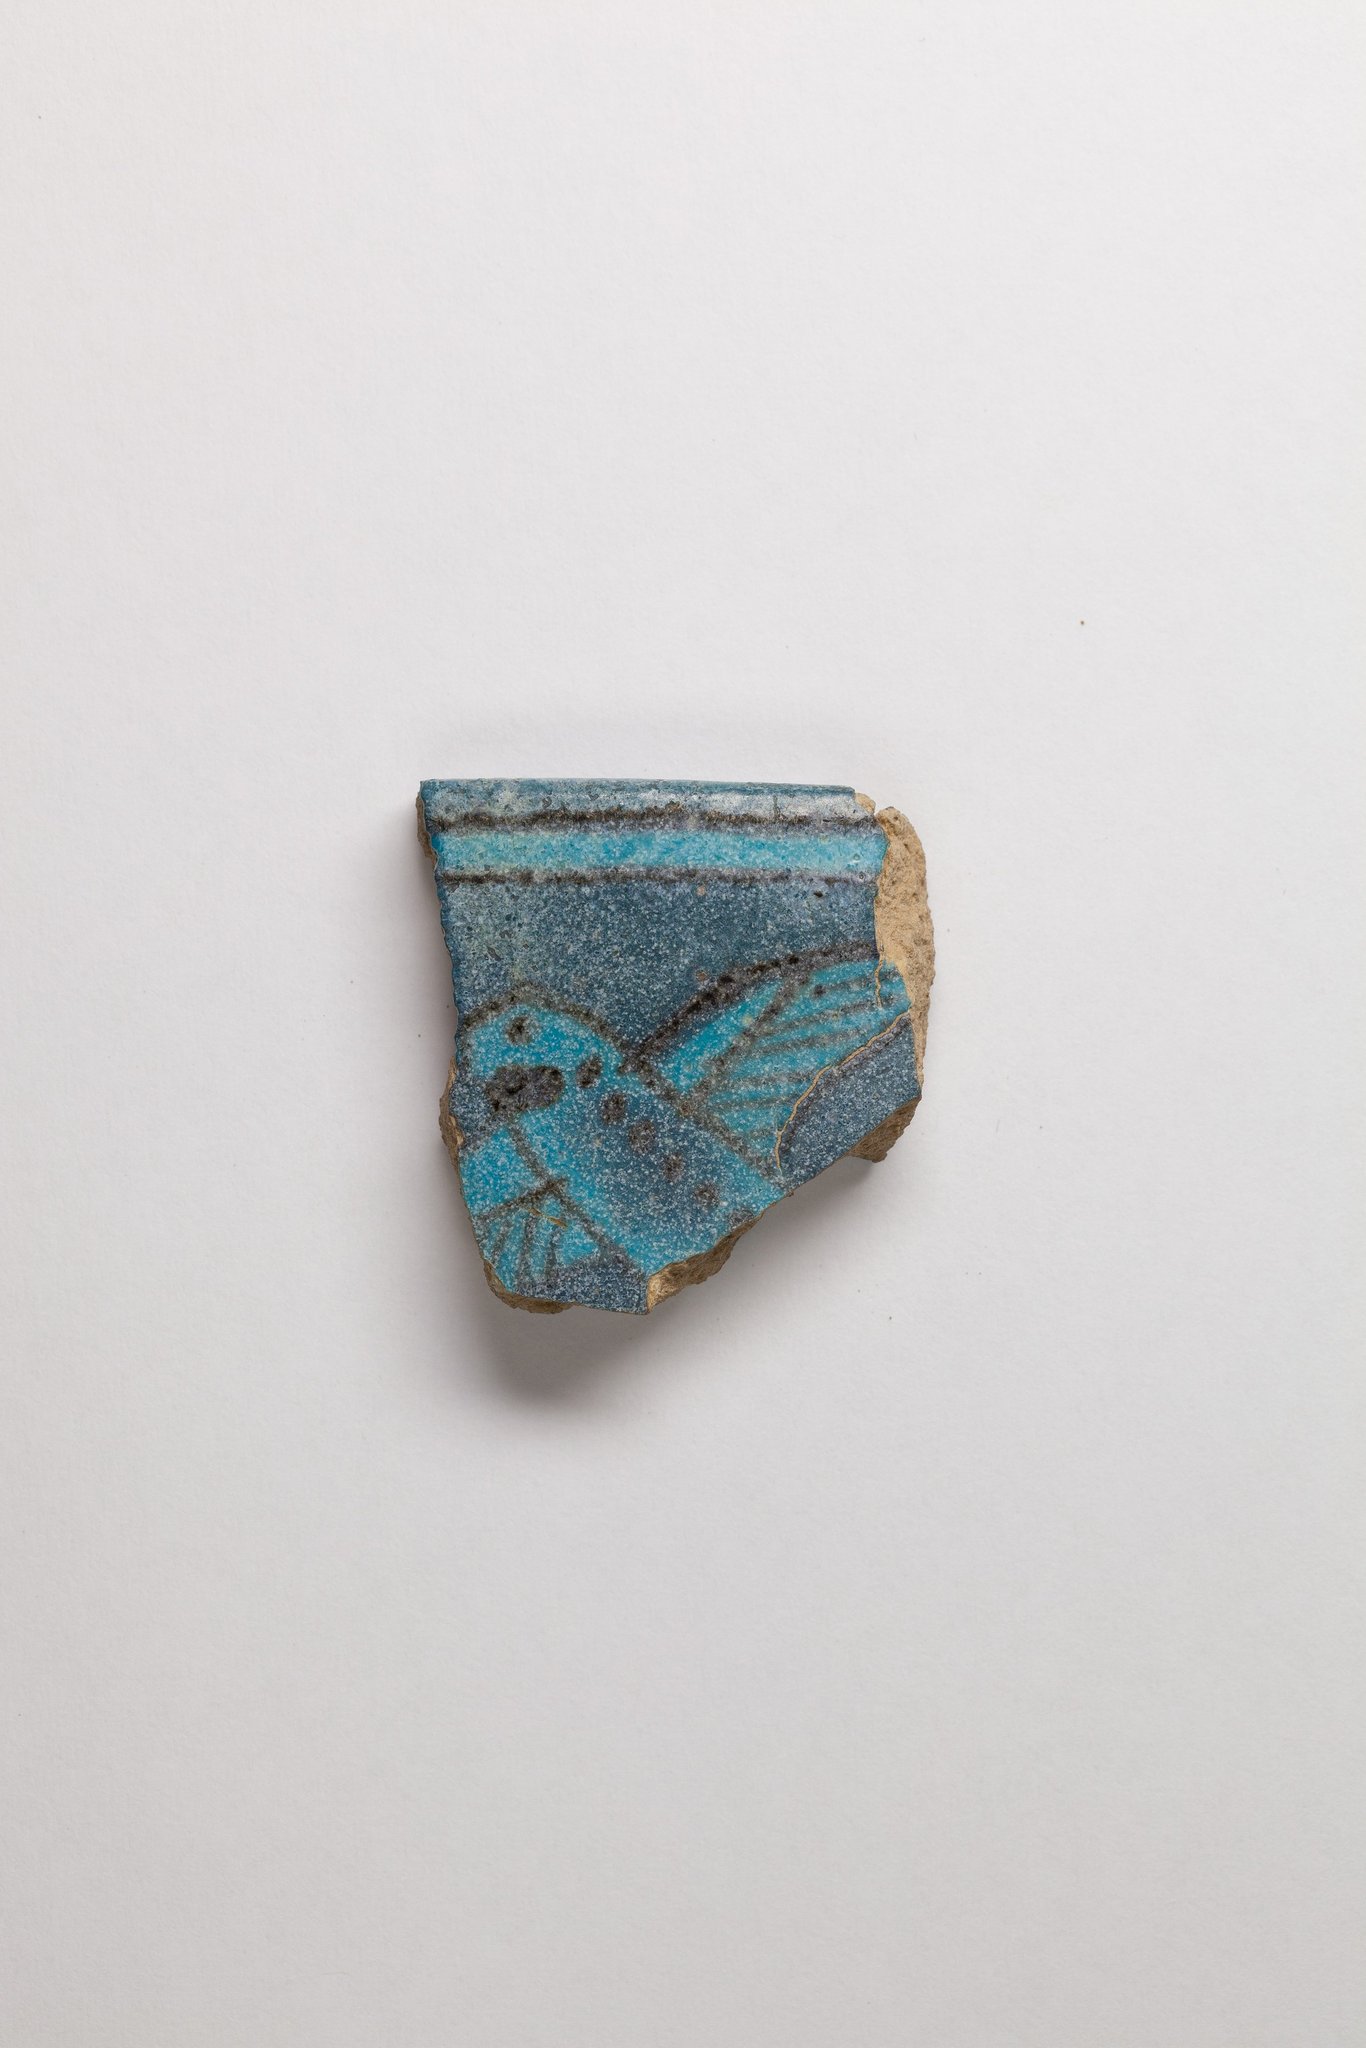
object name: vase fragment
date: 1981-1640 BCE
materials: faience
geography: egypt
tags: birds